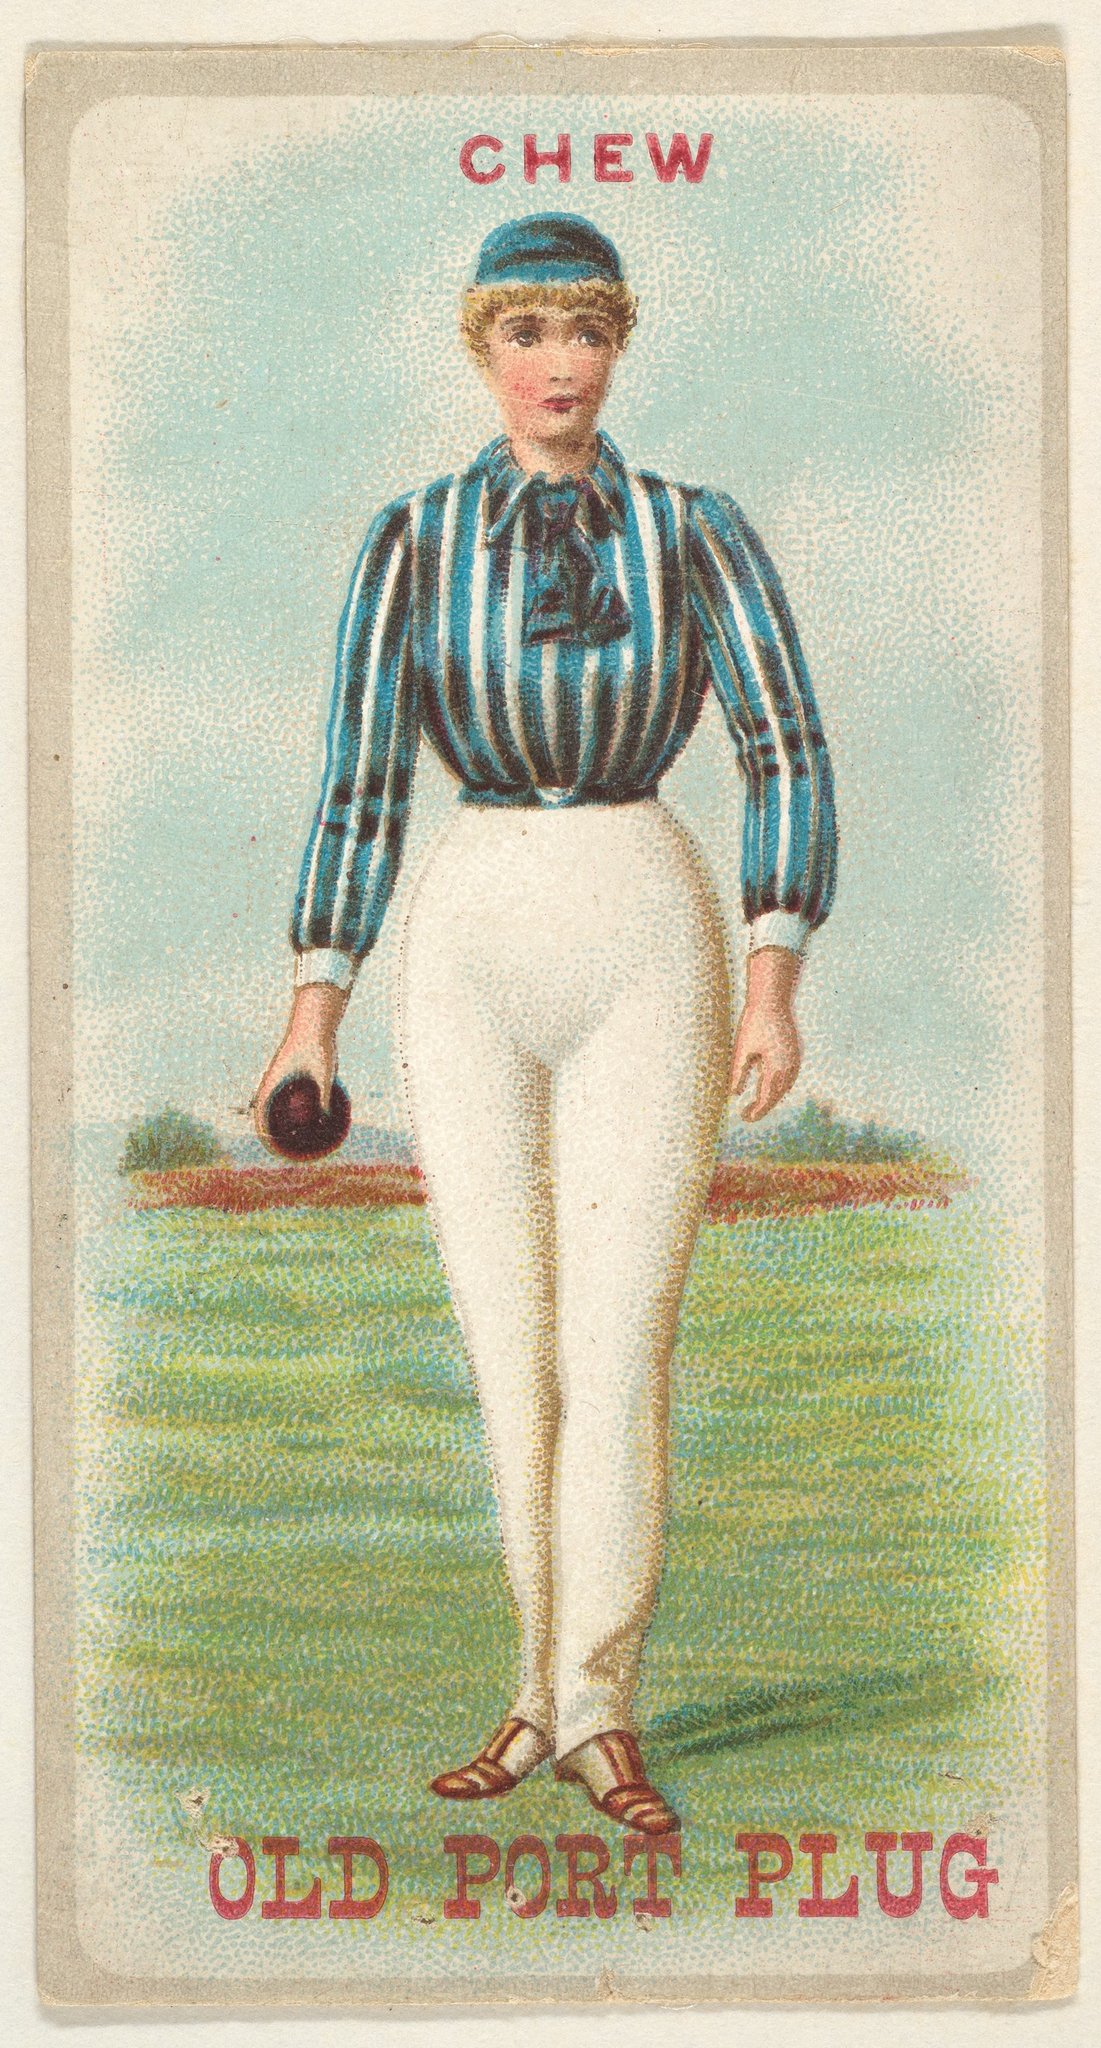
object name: print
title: From the Sports Girls series (N463) for Old Port Plug Tobacco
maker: old port plug tobacco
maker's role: publisher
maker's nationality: american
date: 1889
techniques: color lithograph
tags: portraits,women,athletes